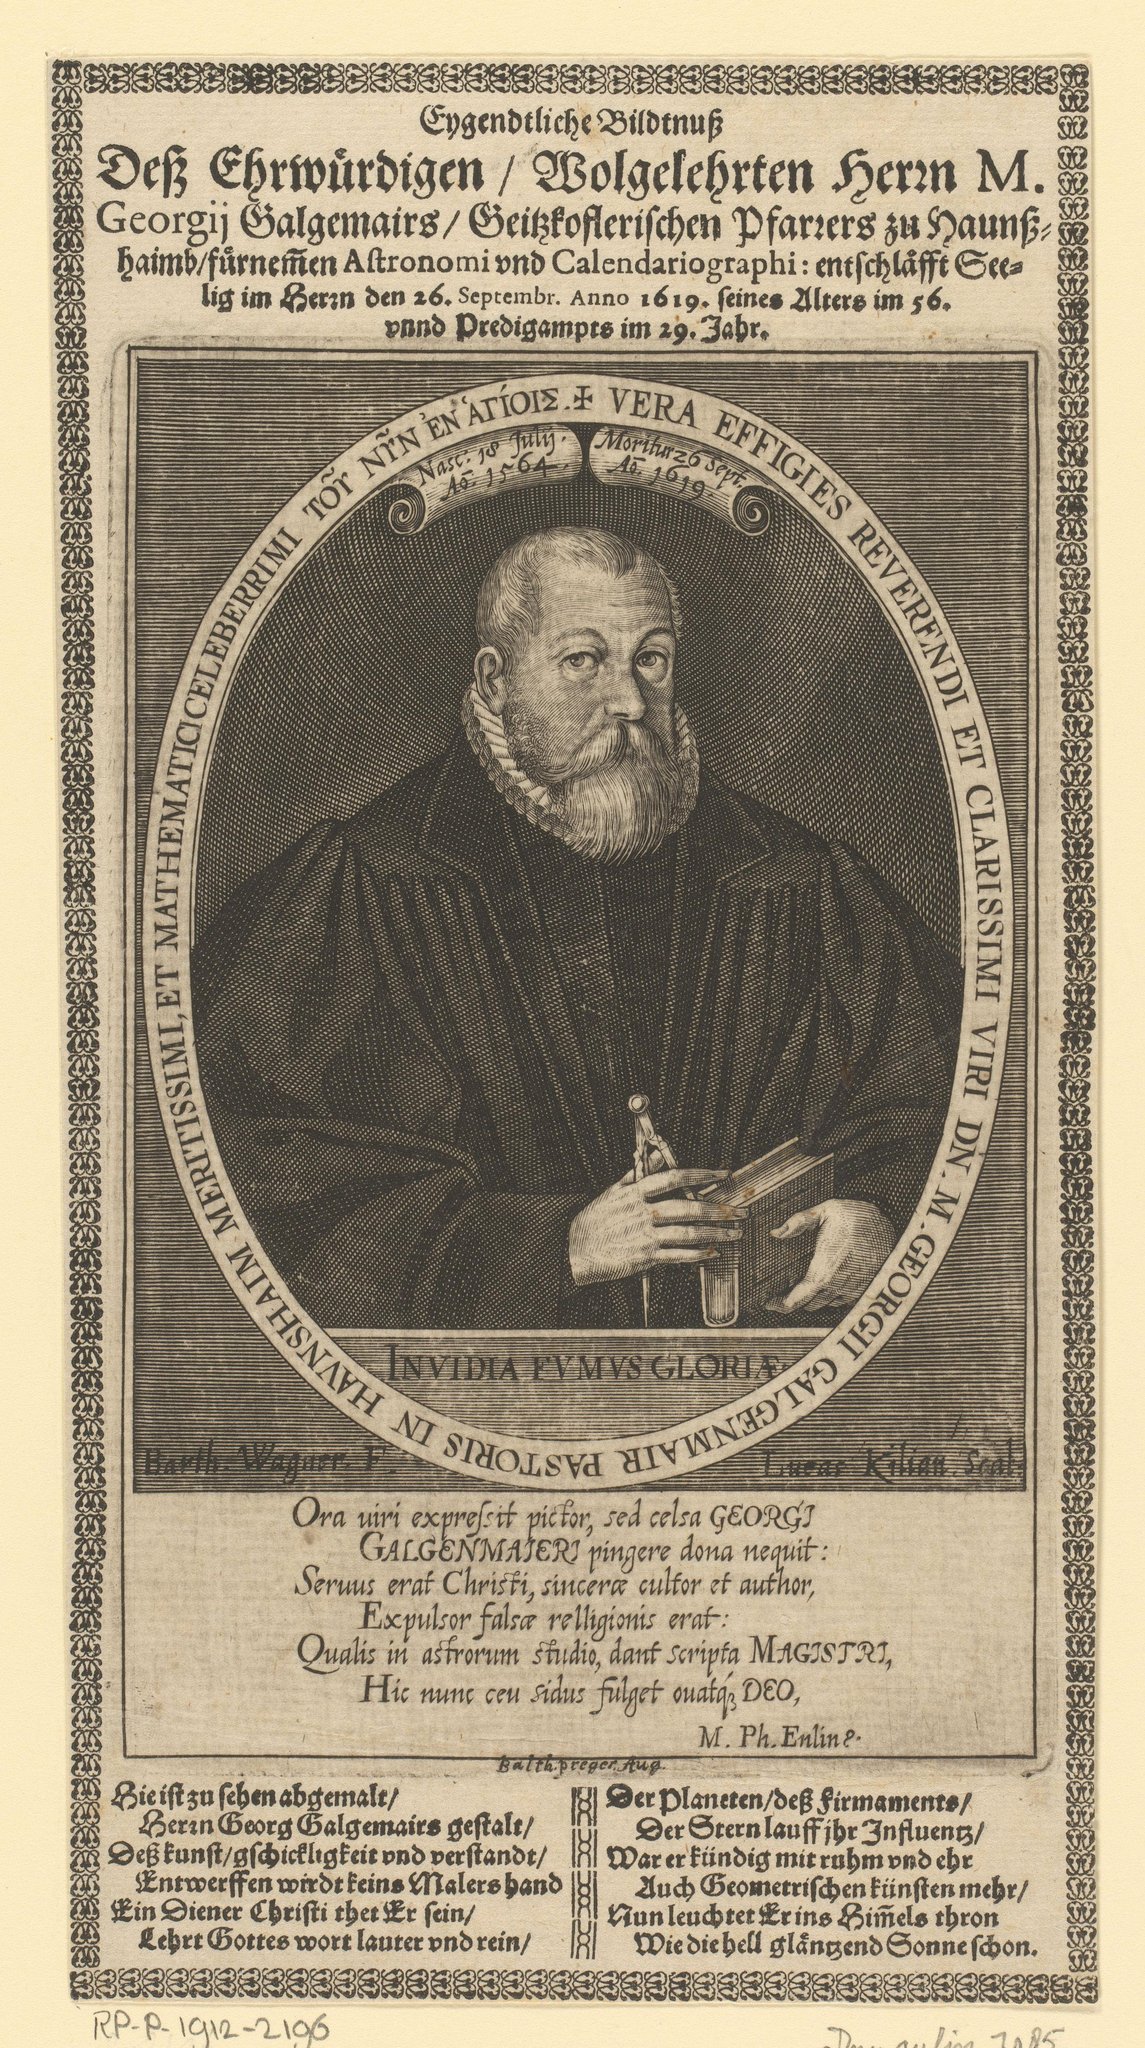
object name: print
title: Portret van Georg Galgemair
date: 1619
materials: paper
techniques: engraving, letterpress printing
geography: augsburg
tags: historical persons, book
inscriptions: collector's mark: Lugt 2228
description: Boven het portret een beschrijving van de geportretteerde. Onder het portret een zesregelig vers.